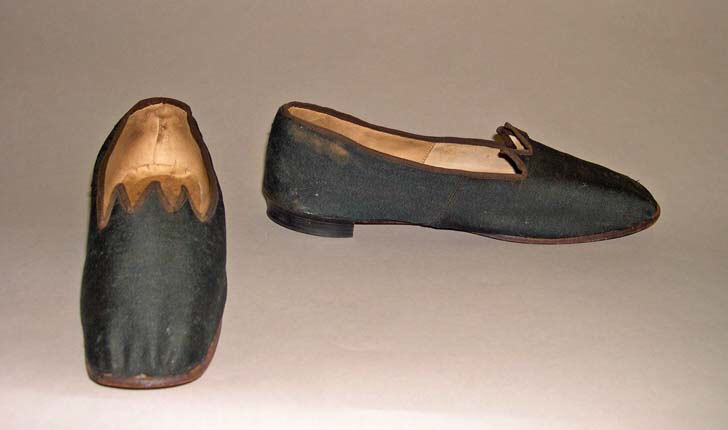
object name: slipper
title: Slippers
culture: american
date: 1850-1859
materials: leather, wool